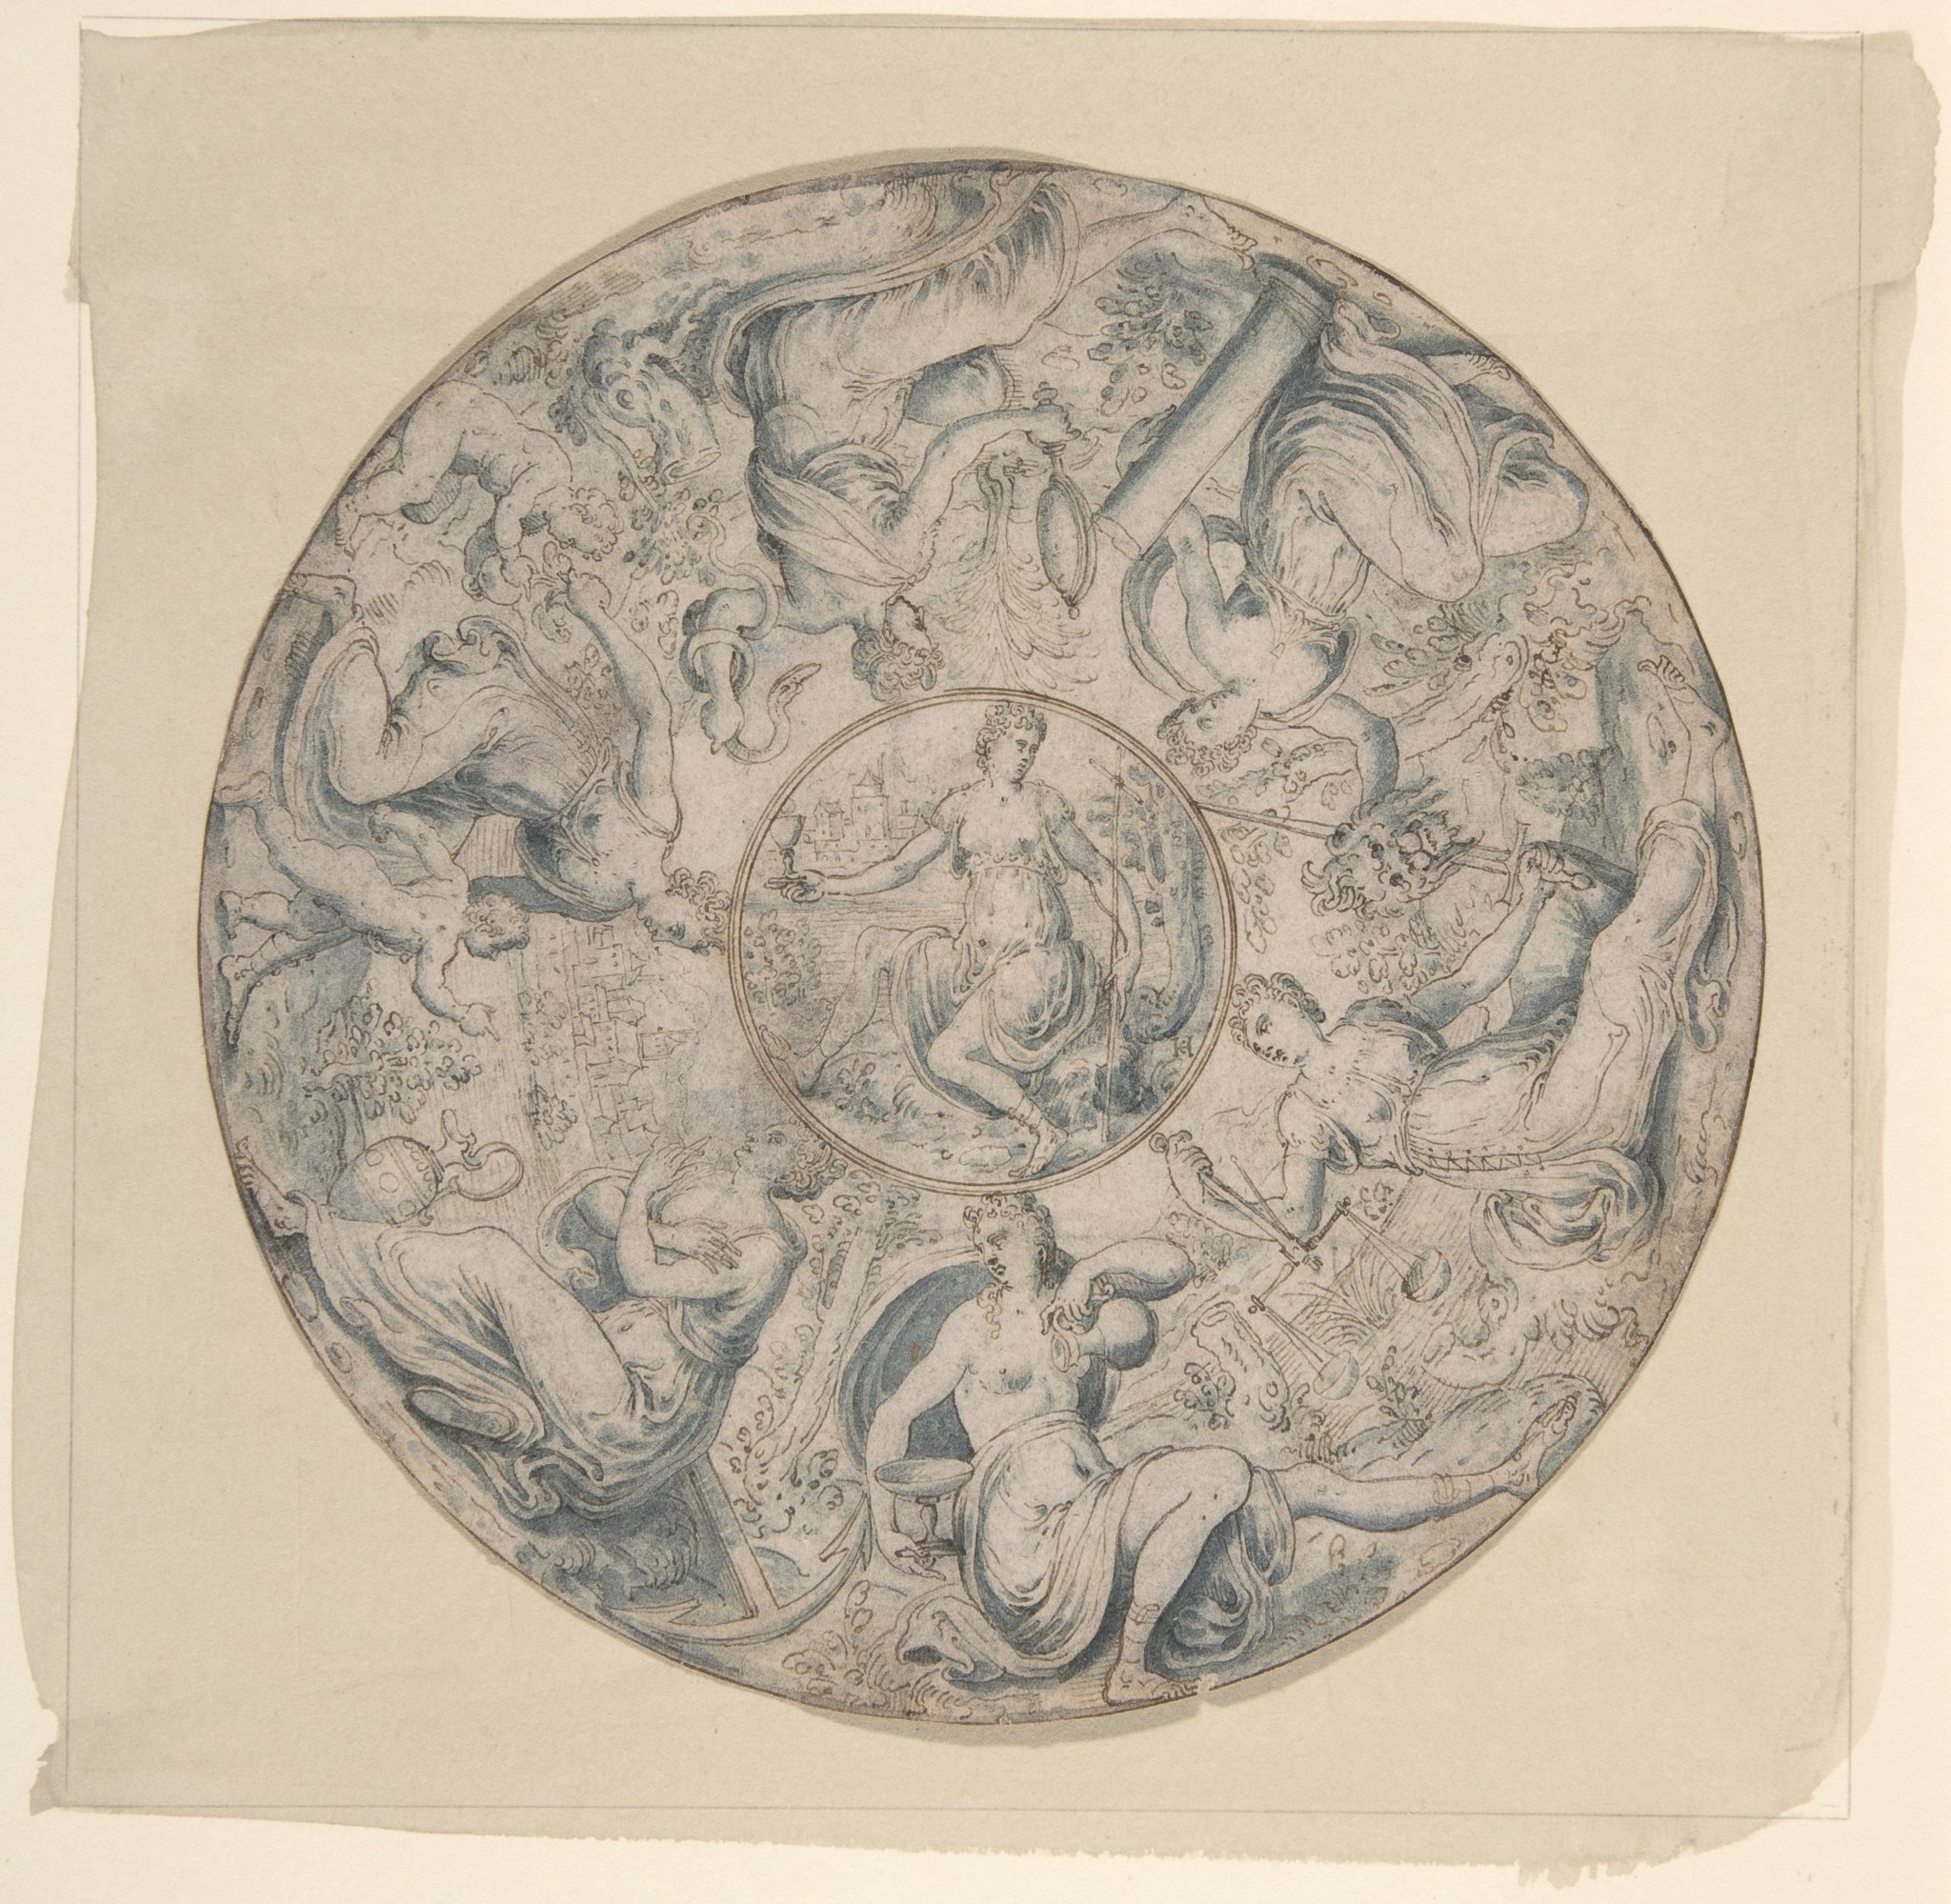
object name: drawing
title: The Seven Virtues in a Roundel, with Faith at the Center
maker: jan collaert i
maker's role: artist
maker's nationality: netherlandish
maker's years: 1530-1581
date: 1534-1566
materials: ink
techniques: pen, transfer, wash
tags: women